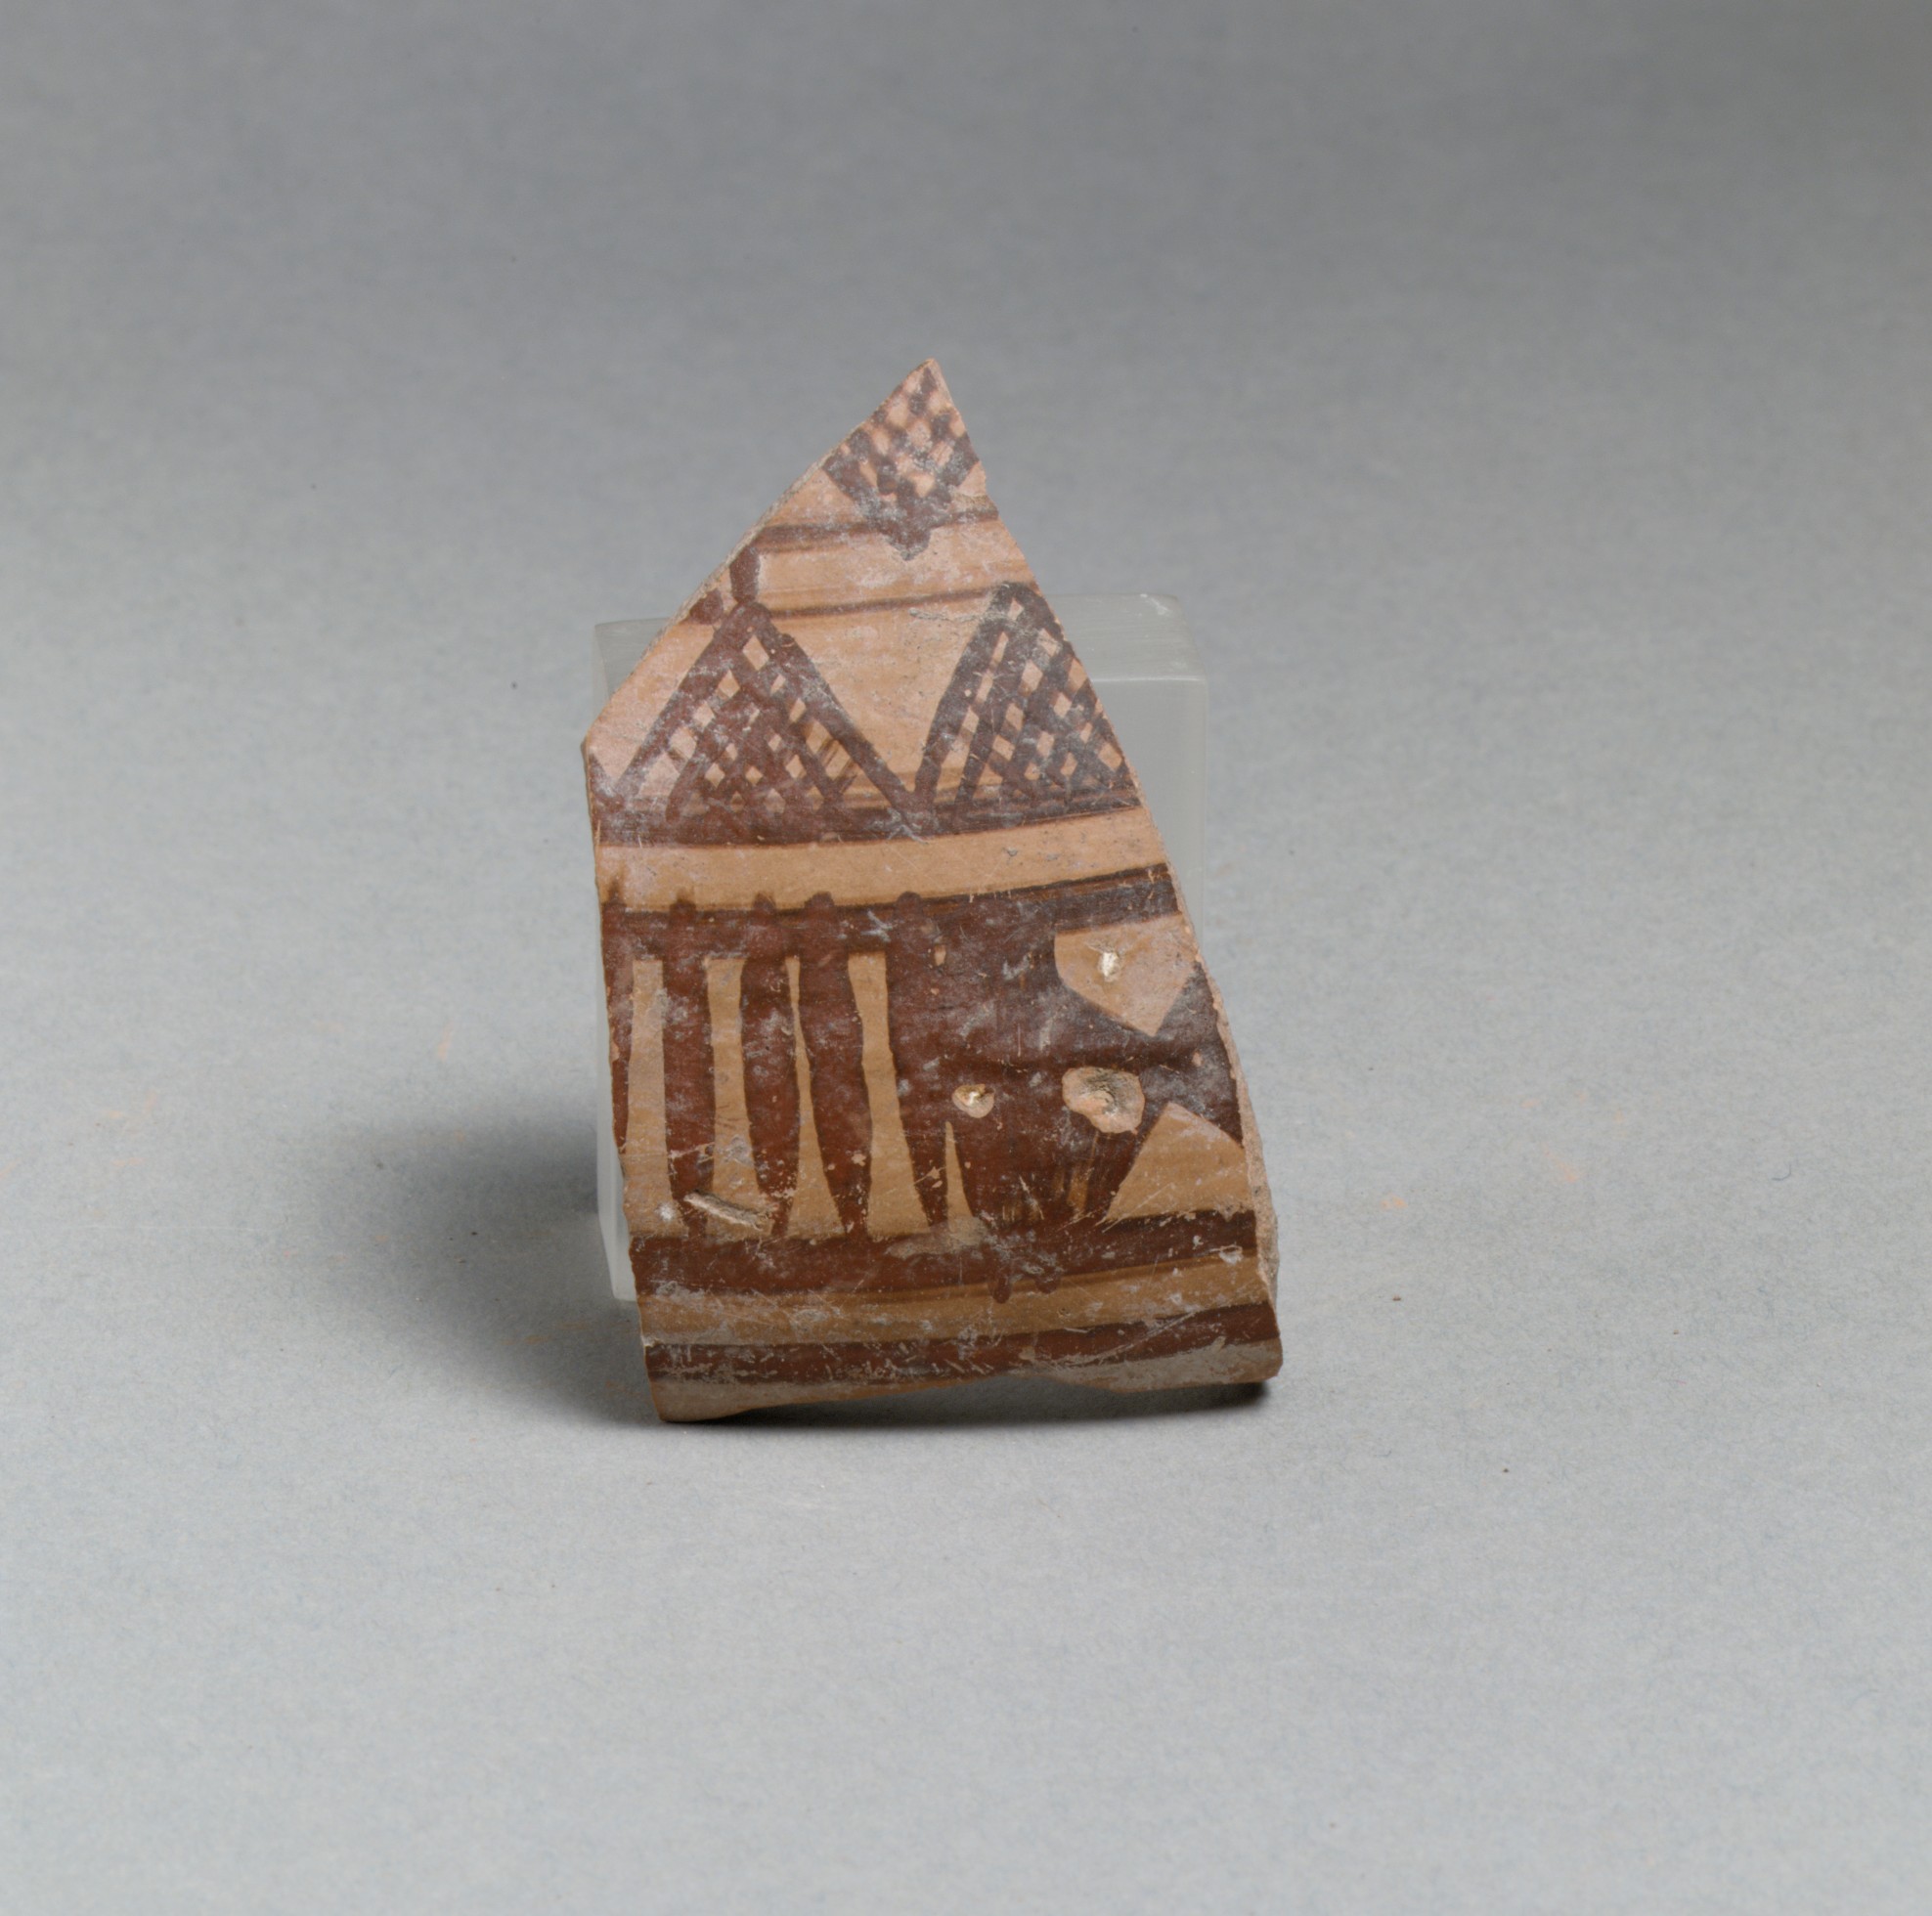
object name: vase fragment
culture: greek or lydian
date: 800-700 BCE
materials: terracotta